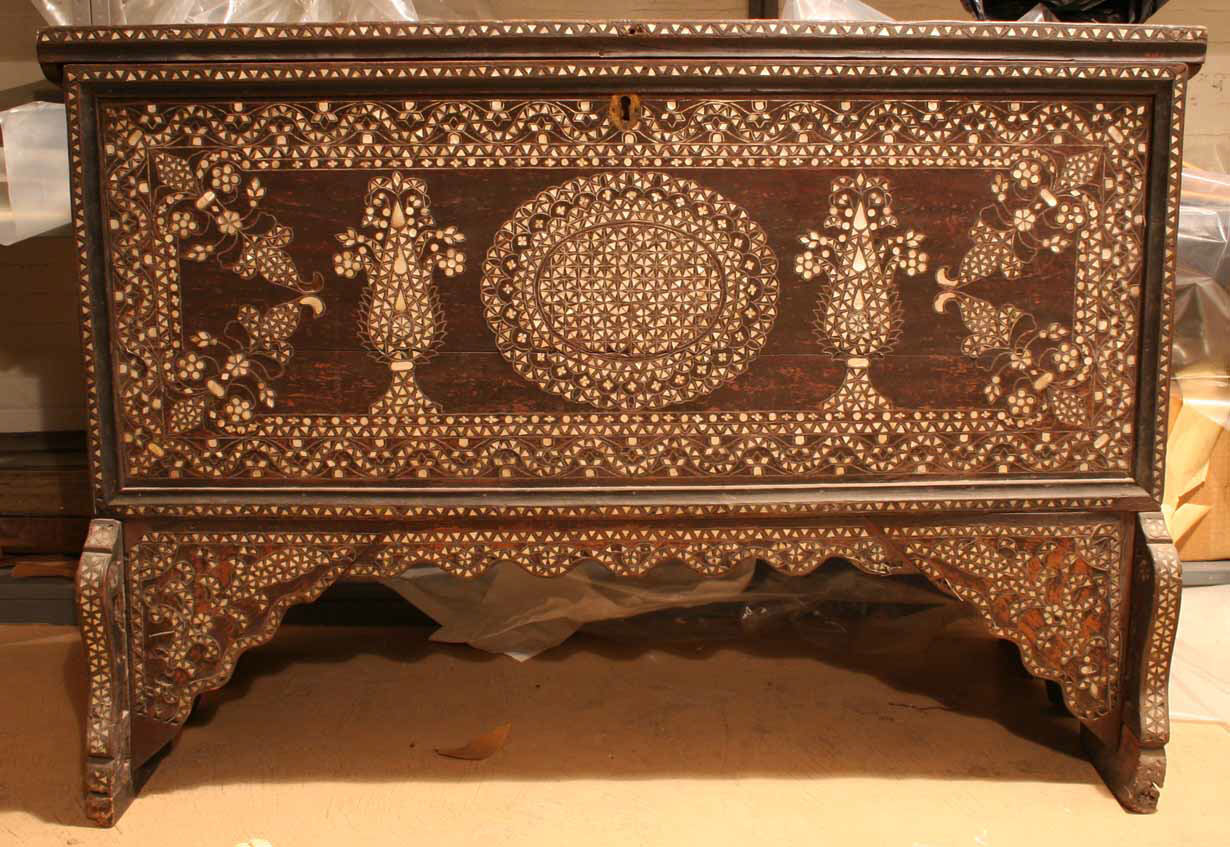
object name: chest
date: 1701-1800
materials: mother of pearl, wood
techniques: inlay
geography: syria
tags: chests